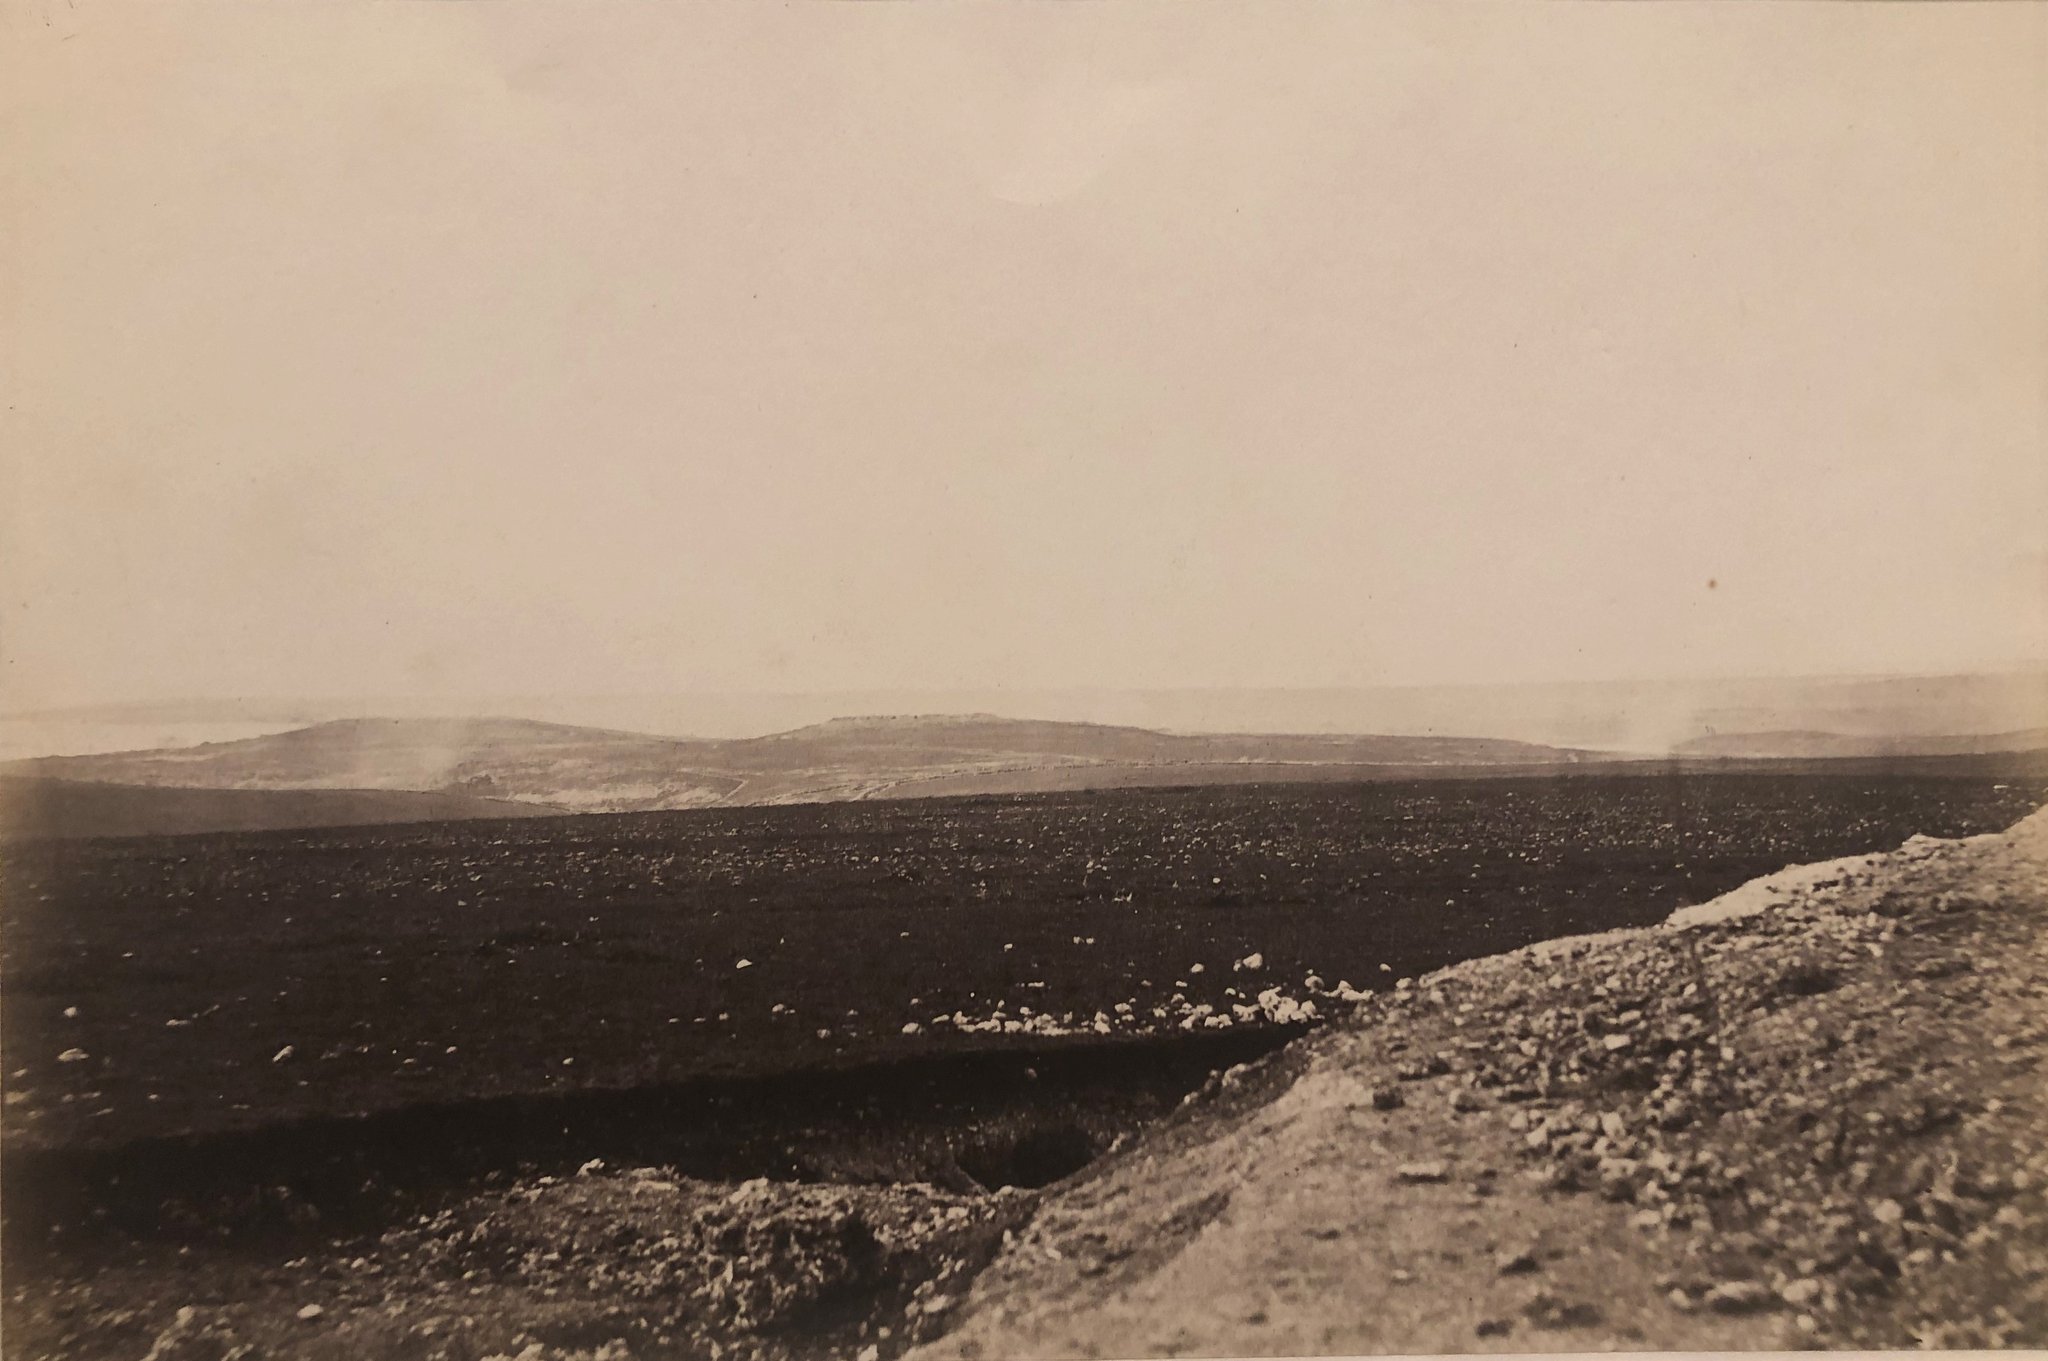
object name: photograph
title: The Mamelon and Malakoff from front of Mortar Battery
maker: roger fenton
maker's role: artist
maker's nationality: english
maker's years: 1819-1869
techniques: glass negative, salted paper print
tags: landscapes